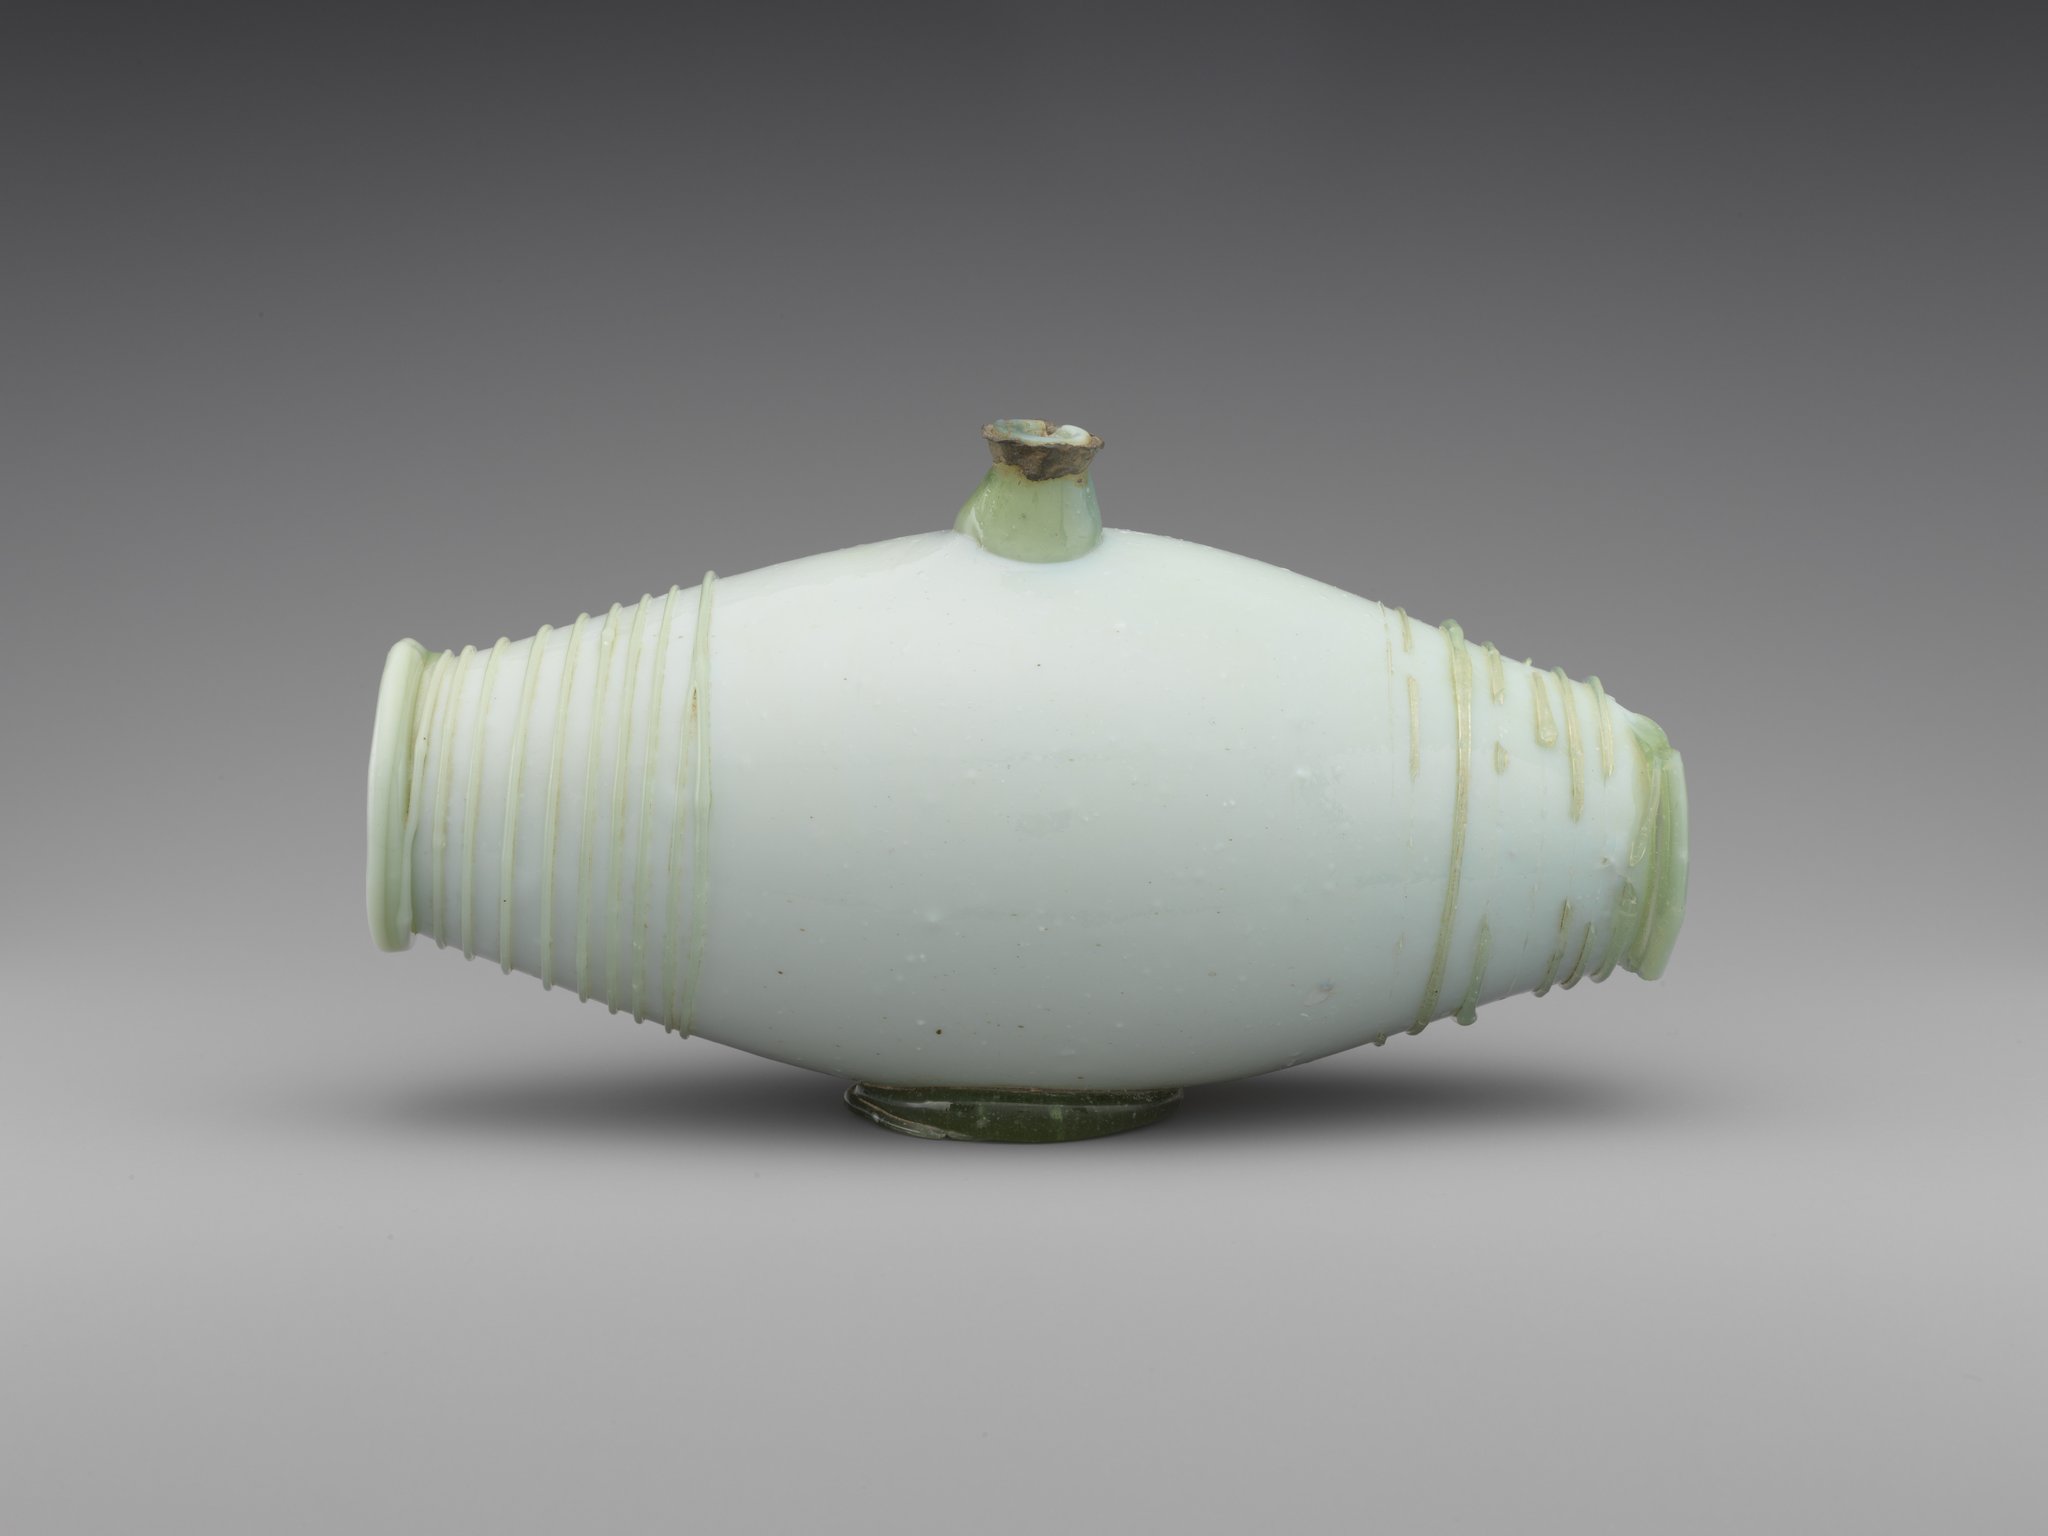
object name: flask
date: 1601-1700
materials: glass